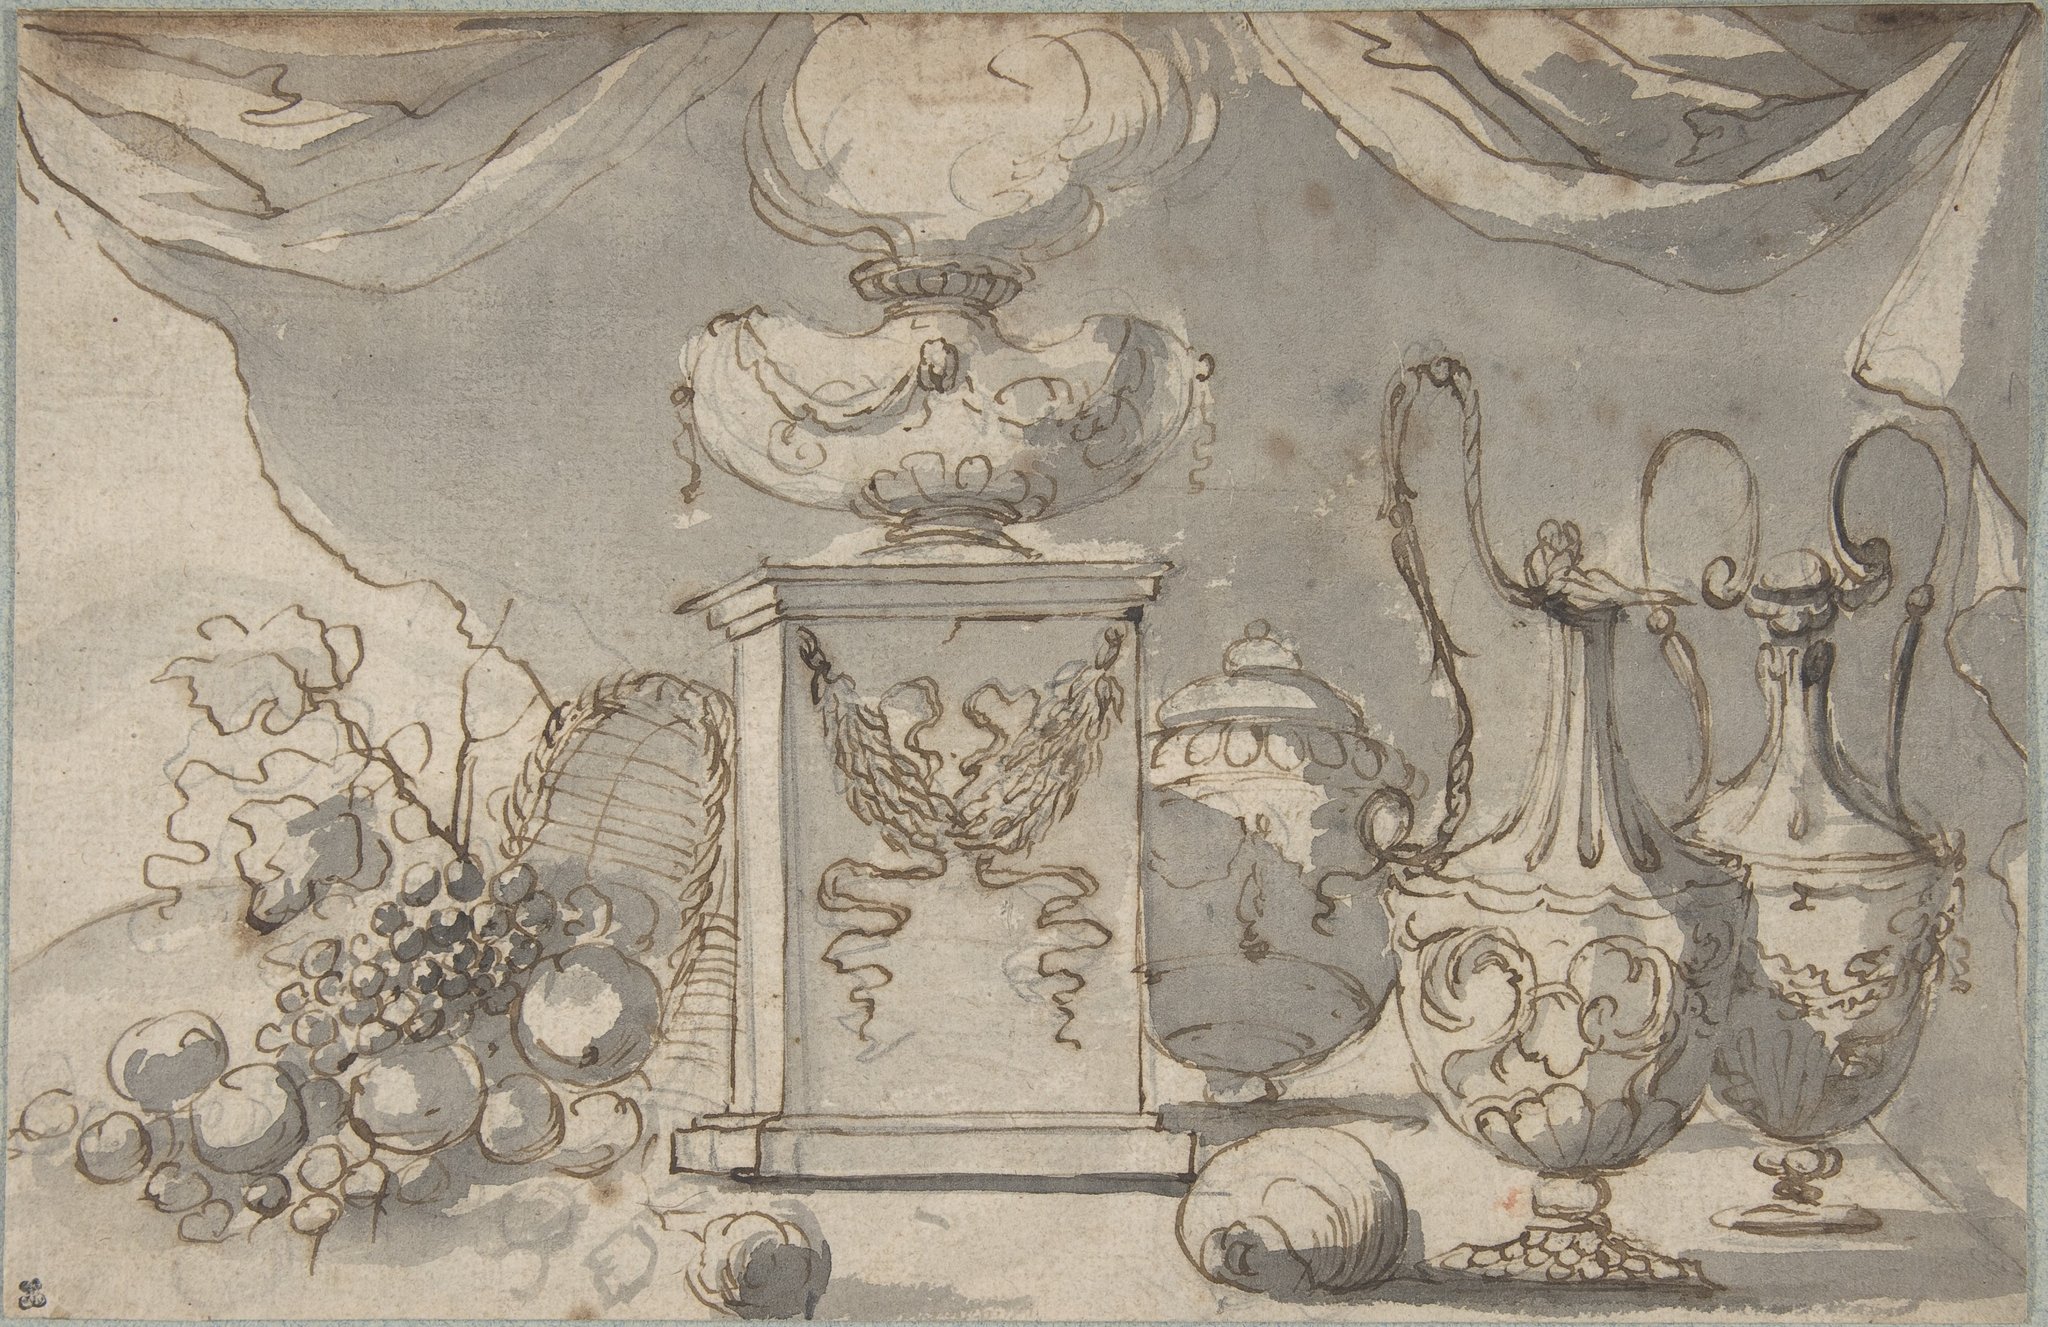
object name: drawing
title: Still Life: Vases, a Cassolette on a Pedestal, and an Overturned Basket of Fruit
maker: jean jacques lagrenée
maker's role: artist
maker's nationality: french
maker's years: 1739-1821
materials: graphite, ink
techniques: brush, pen, wash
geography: france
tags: fruit,still life,vases